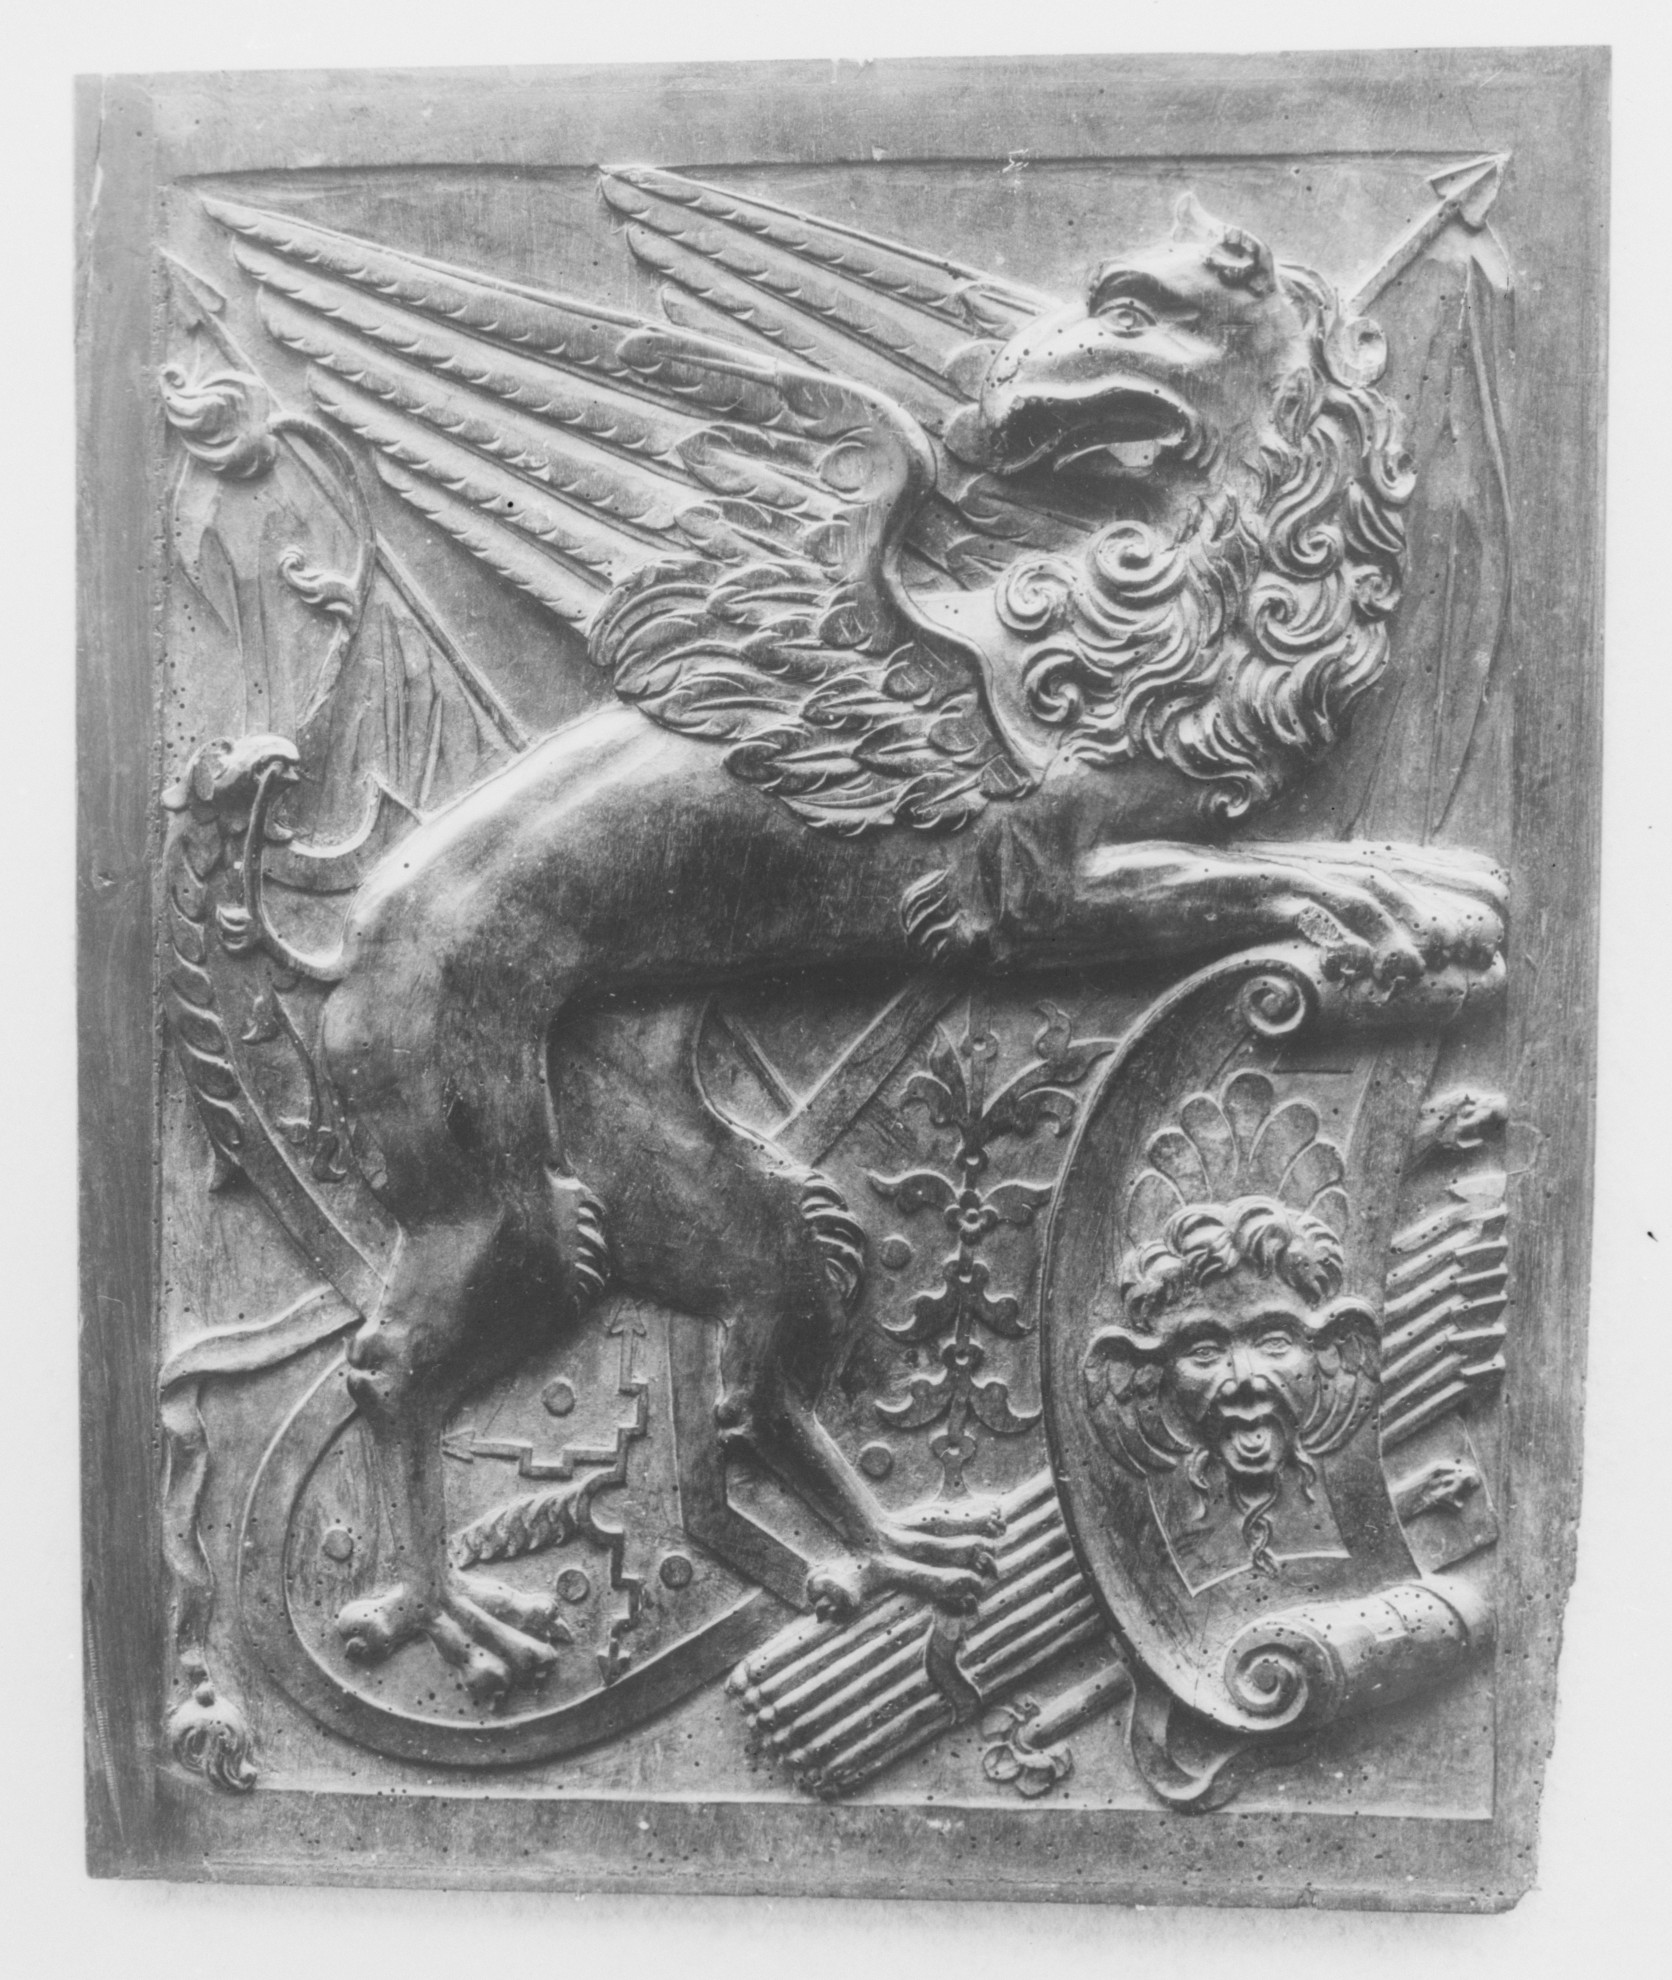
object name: panel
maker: jean goujon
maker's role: maker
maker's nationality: french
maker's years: 1505-1565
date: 1551-1600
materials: wood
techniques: carving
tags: bow and arrow,griffins